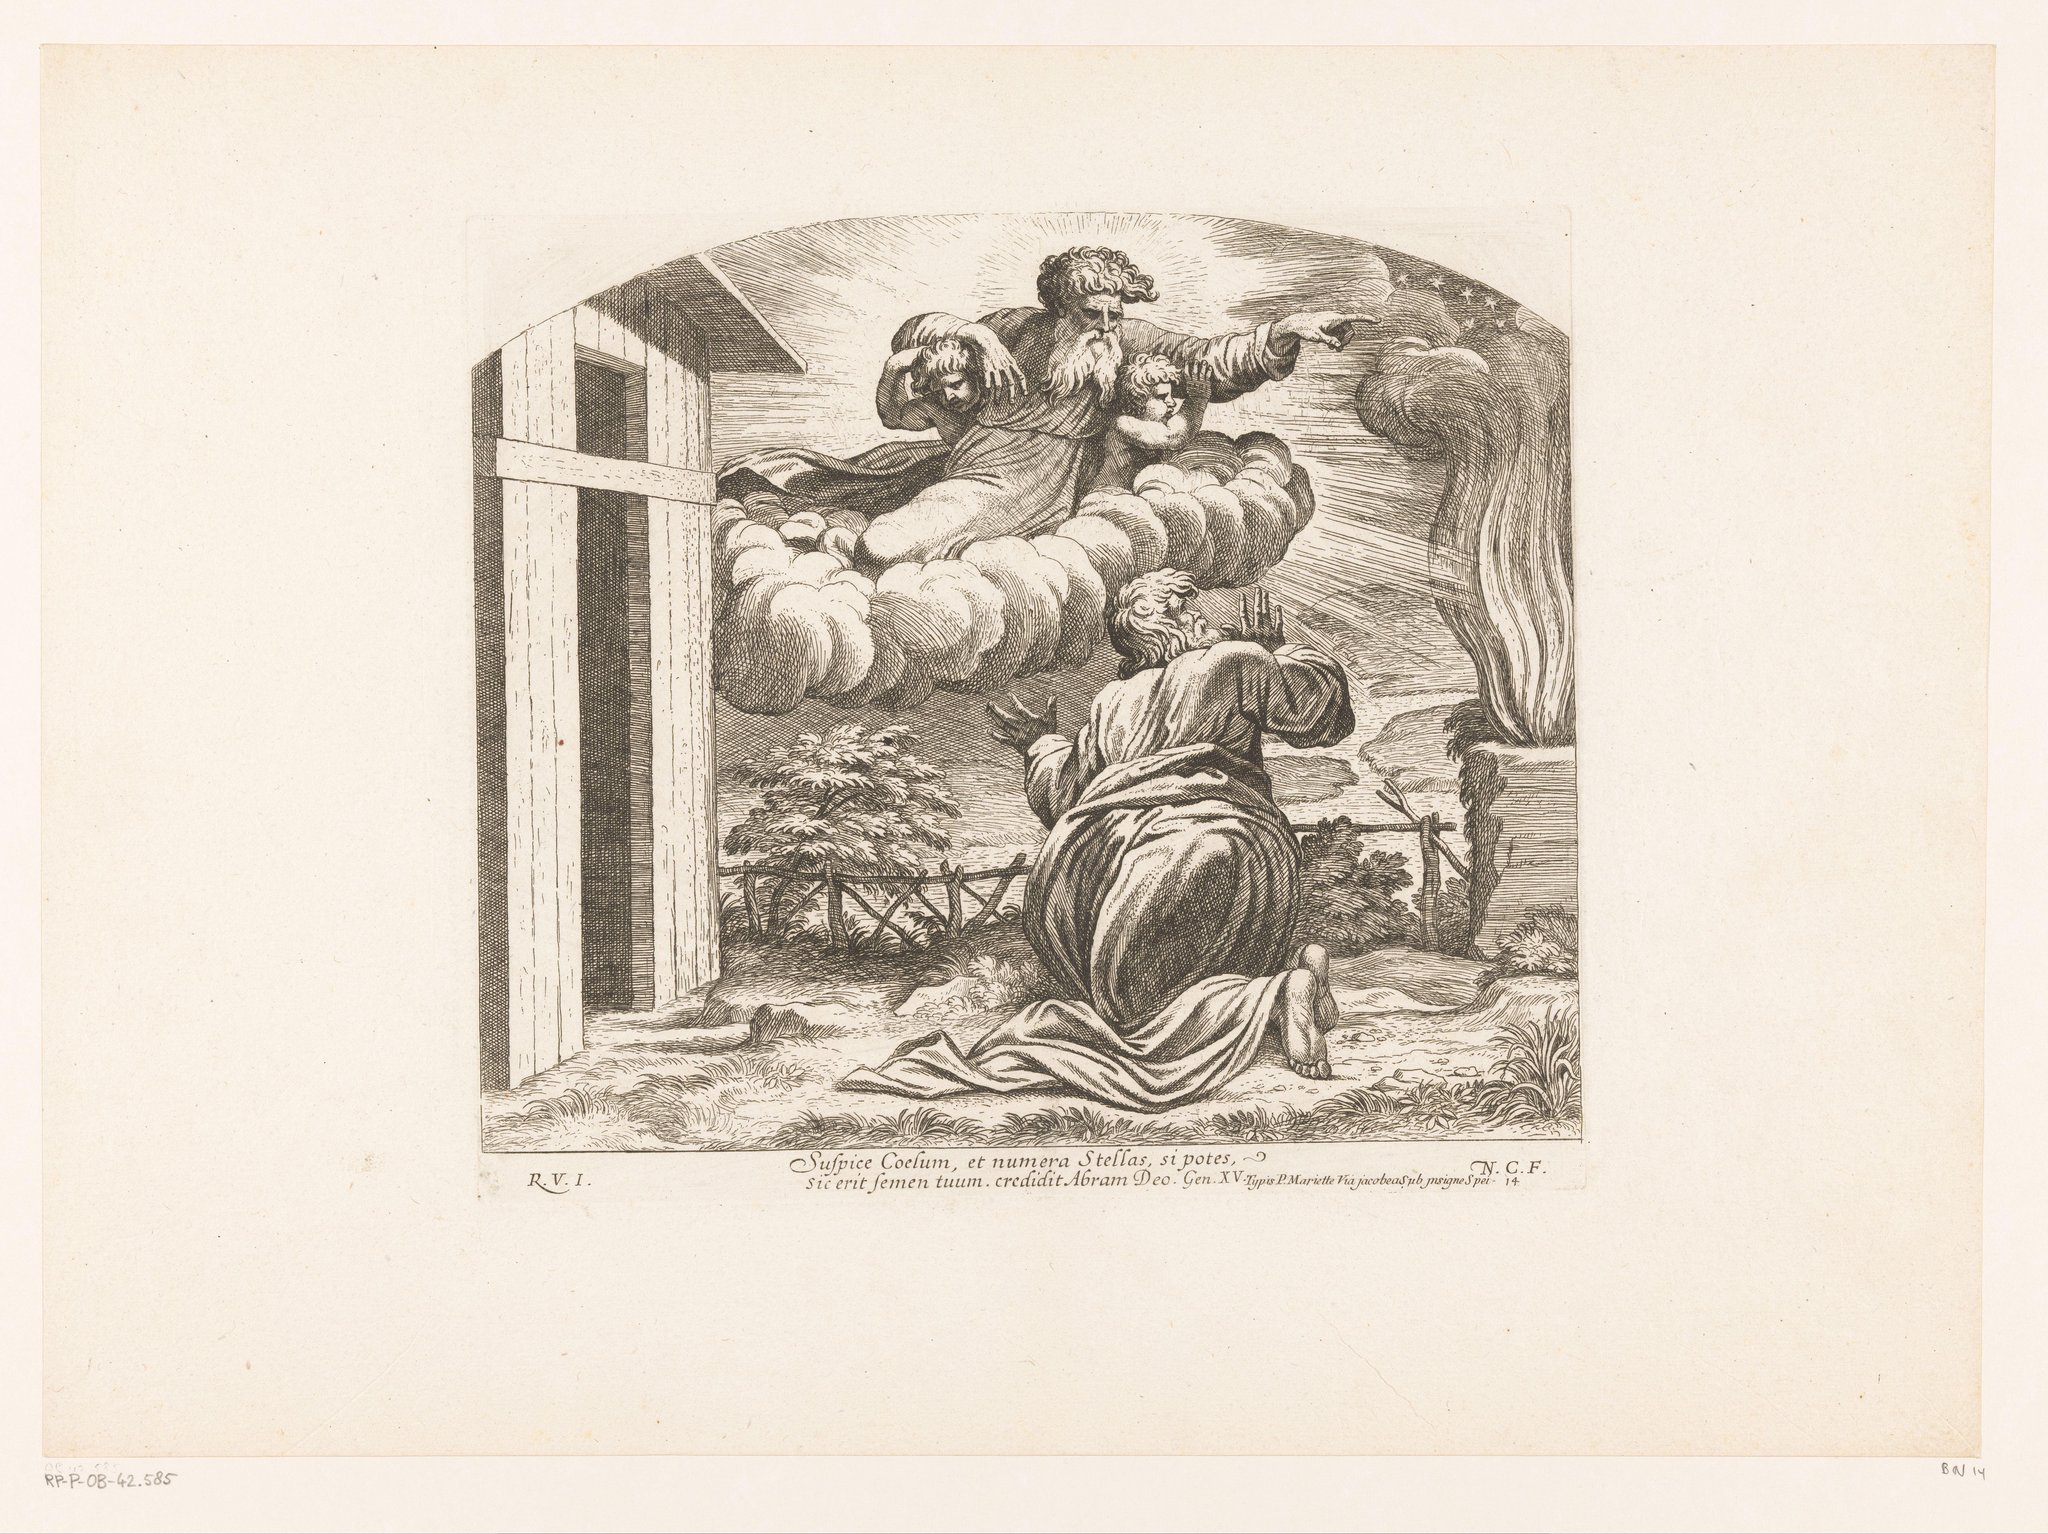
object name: print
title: Sacrae Historiae Acta a Raphael Urbin in Vaticanis xystis ad picturae miraculum expressa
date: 1649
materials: paper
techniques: etching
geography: vatican city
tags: god promises that abraham's seed shall be as numerous as the stars of heaven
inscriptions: collector's mark: Lugt 2228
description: Prent uit de Sacrae Historiae Acta a Raphael Urbin in Vaticanis xystis ad picturae miraculum expressa, ook bekend als de Rafaël Bijbel. De serie bestaat uit 54 platen, waarvan twee titelprenten, de eerste met een opdracht aan Rafaël, de tweede met een opdracht aan Renard. De overige 52 platen betreffen composities naar schilderingen in de Loggia van Rafaël in het Vaticaan. De serie werd in 1649 uitgegeven door Pierre Mariette te Parijs.